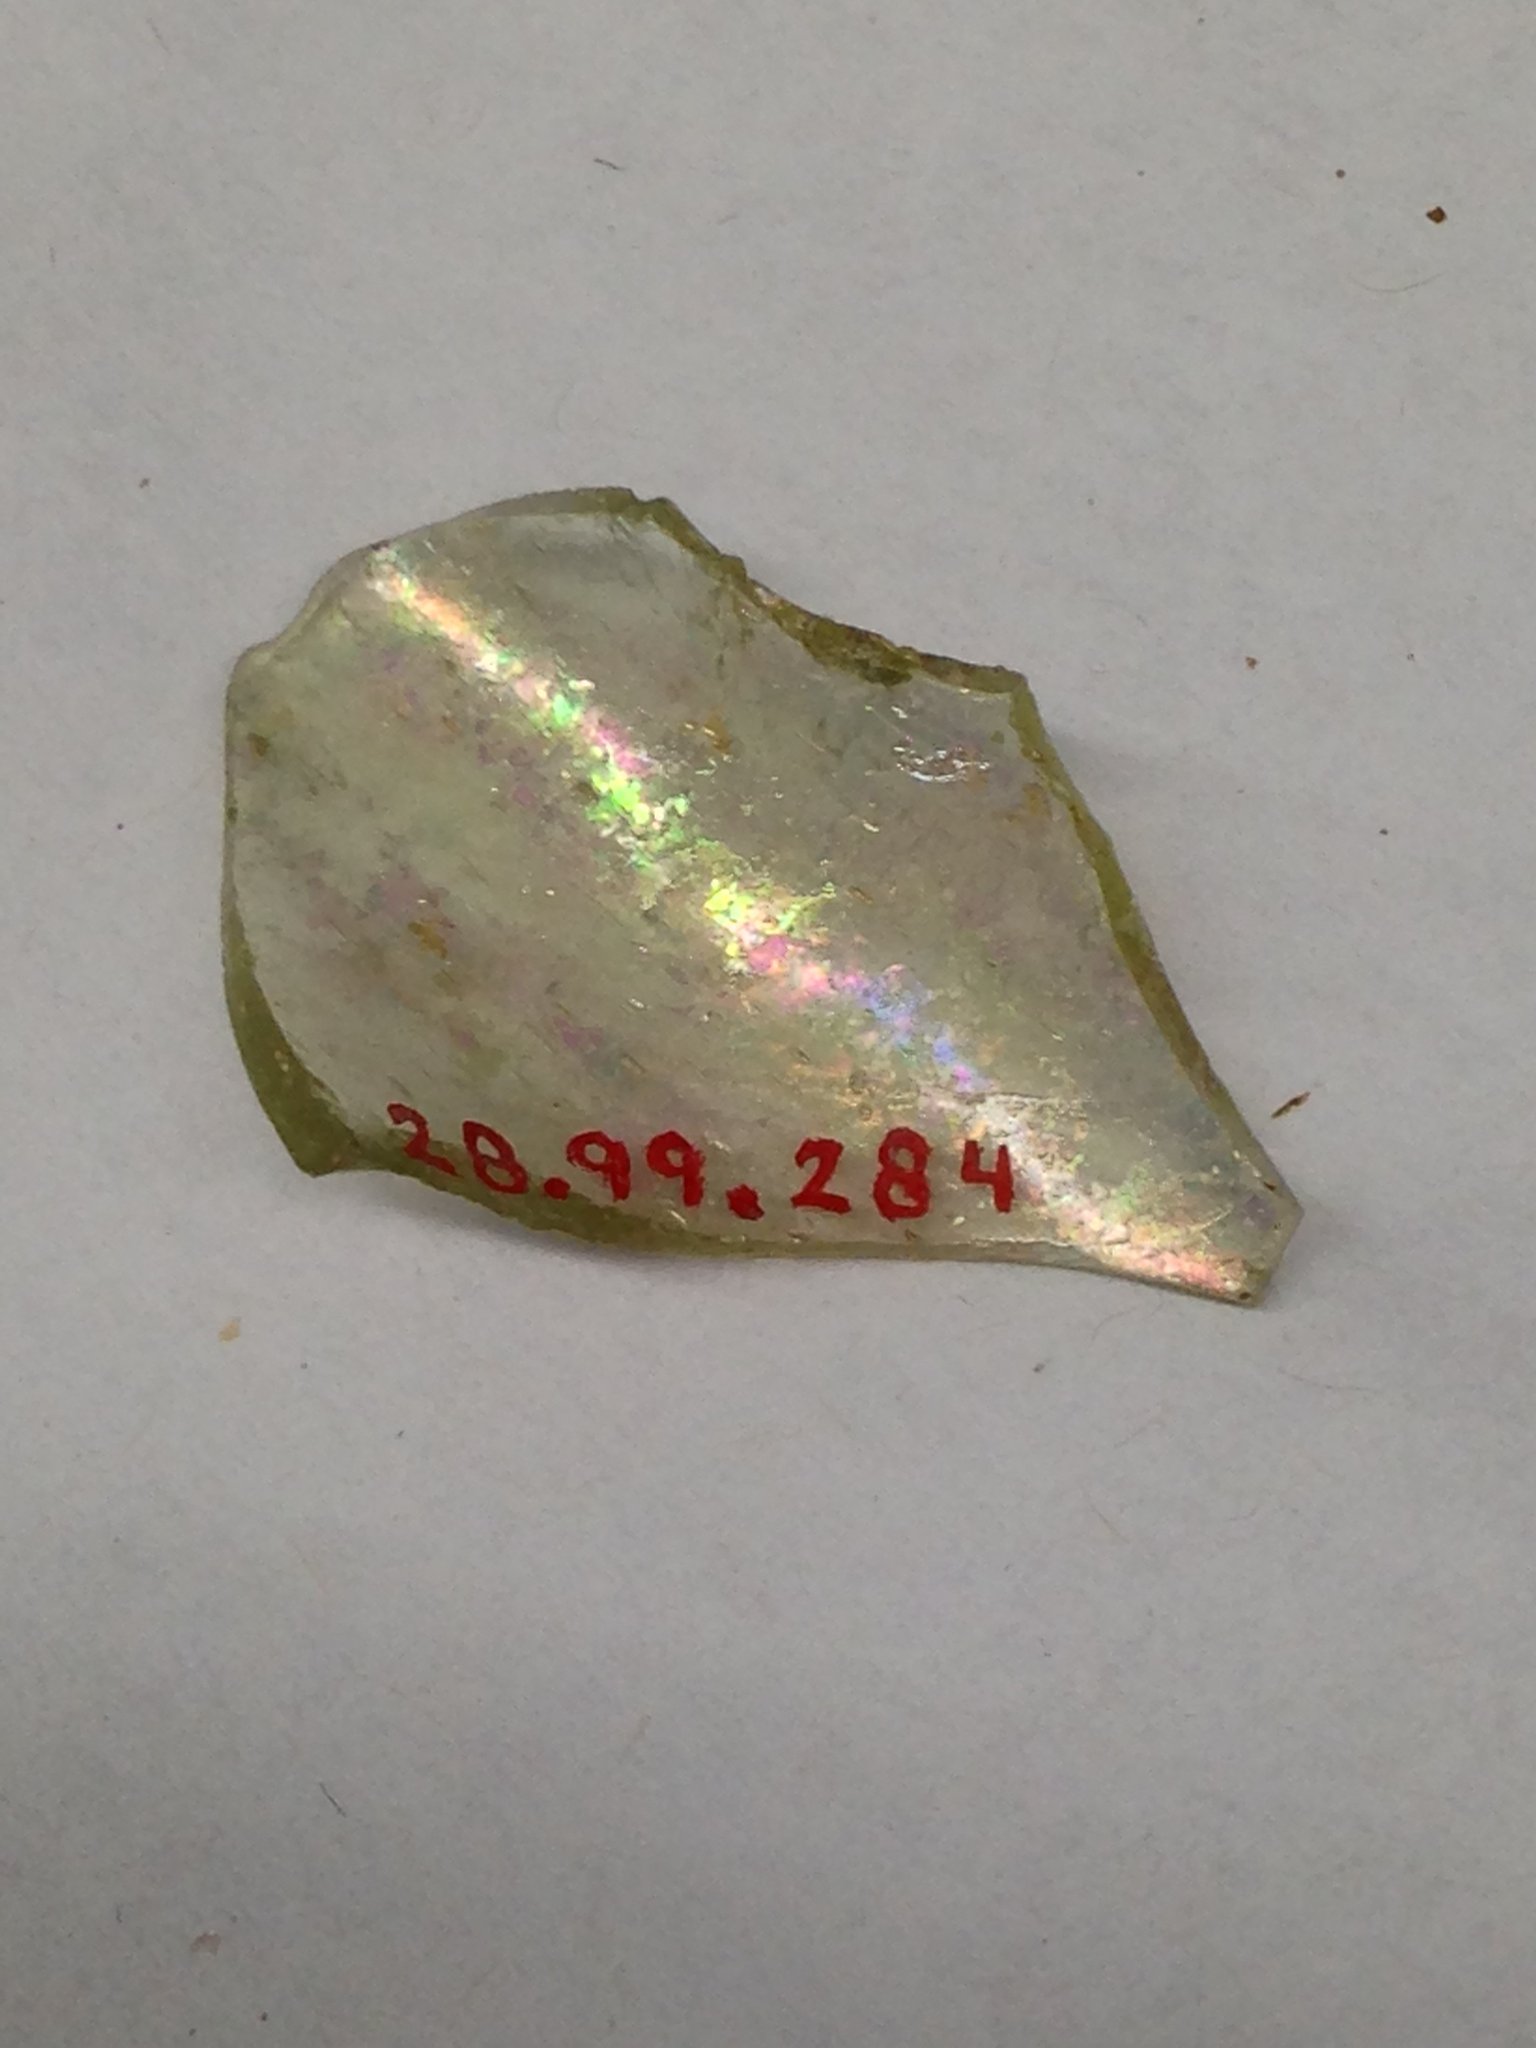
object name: fragment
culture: european or middle eastern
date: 1150-1250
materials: ceramic, glass